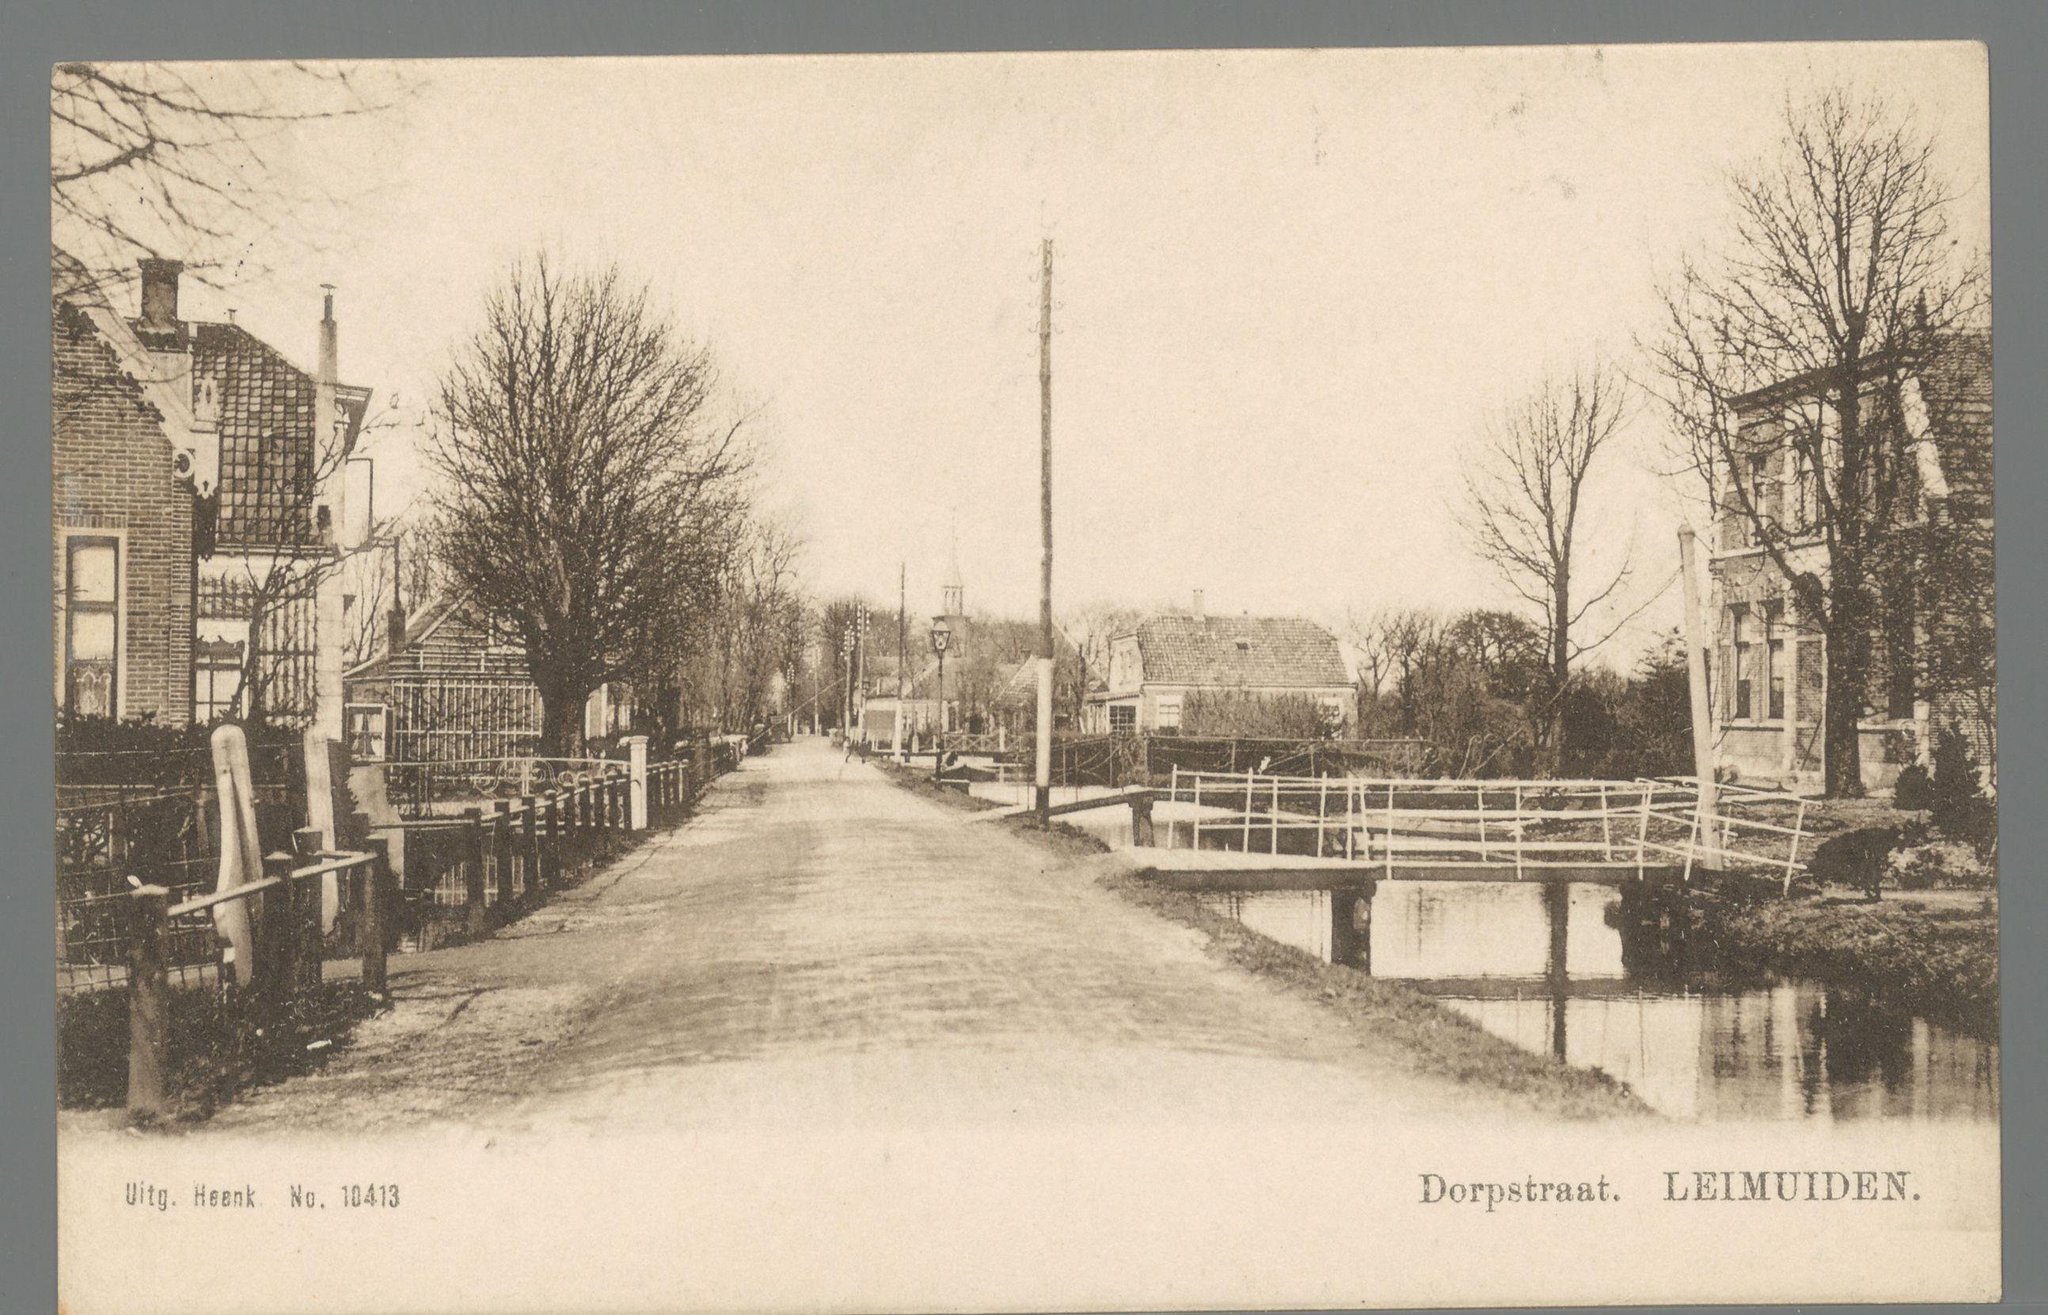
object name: ansichtkaart, prentbriefkaart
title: Dorpstraat. Leimuiden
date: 1897-1905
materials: cardboard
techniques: photograph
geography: leimuiden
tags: canal, bridge in city across river, canal, etc., street